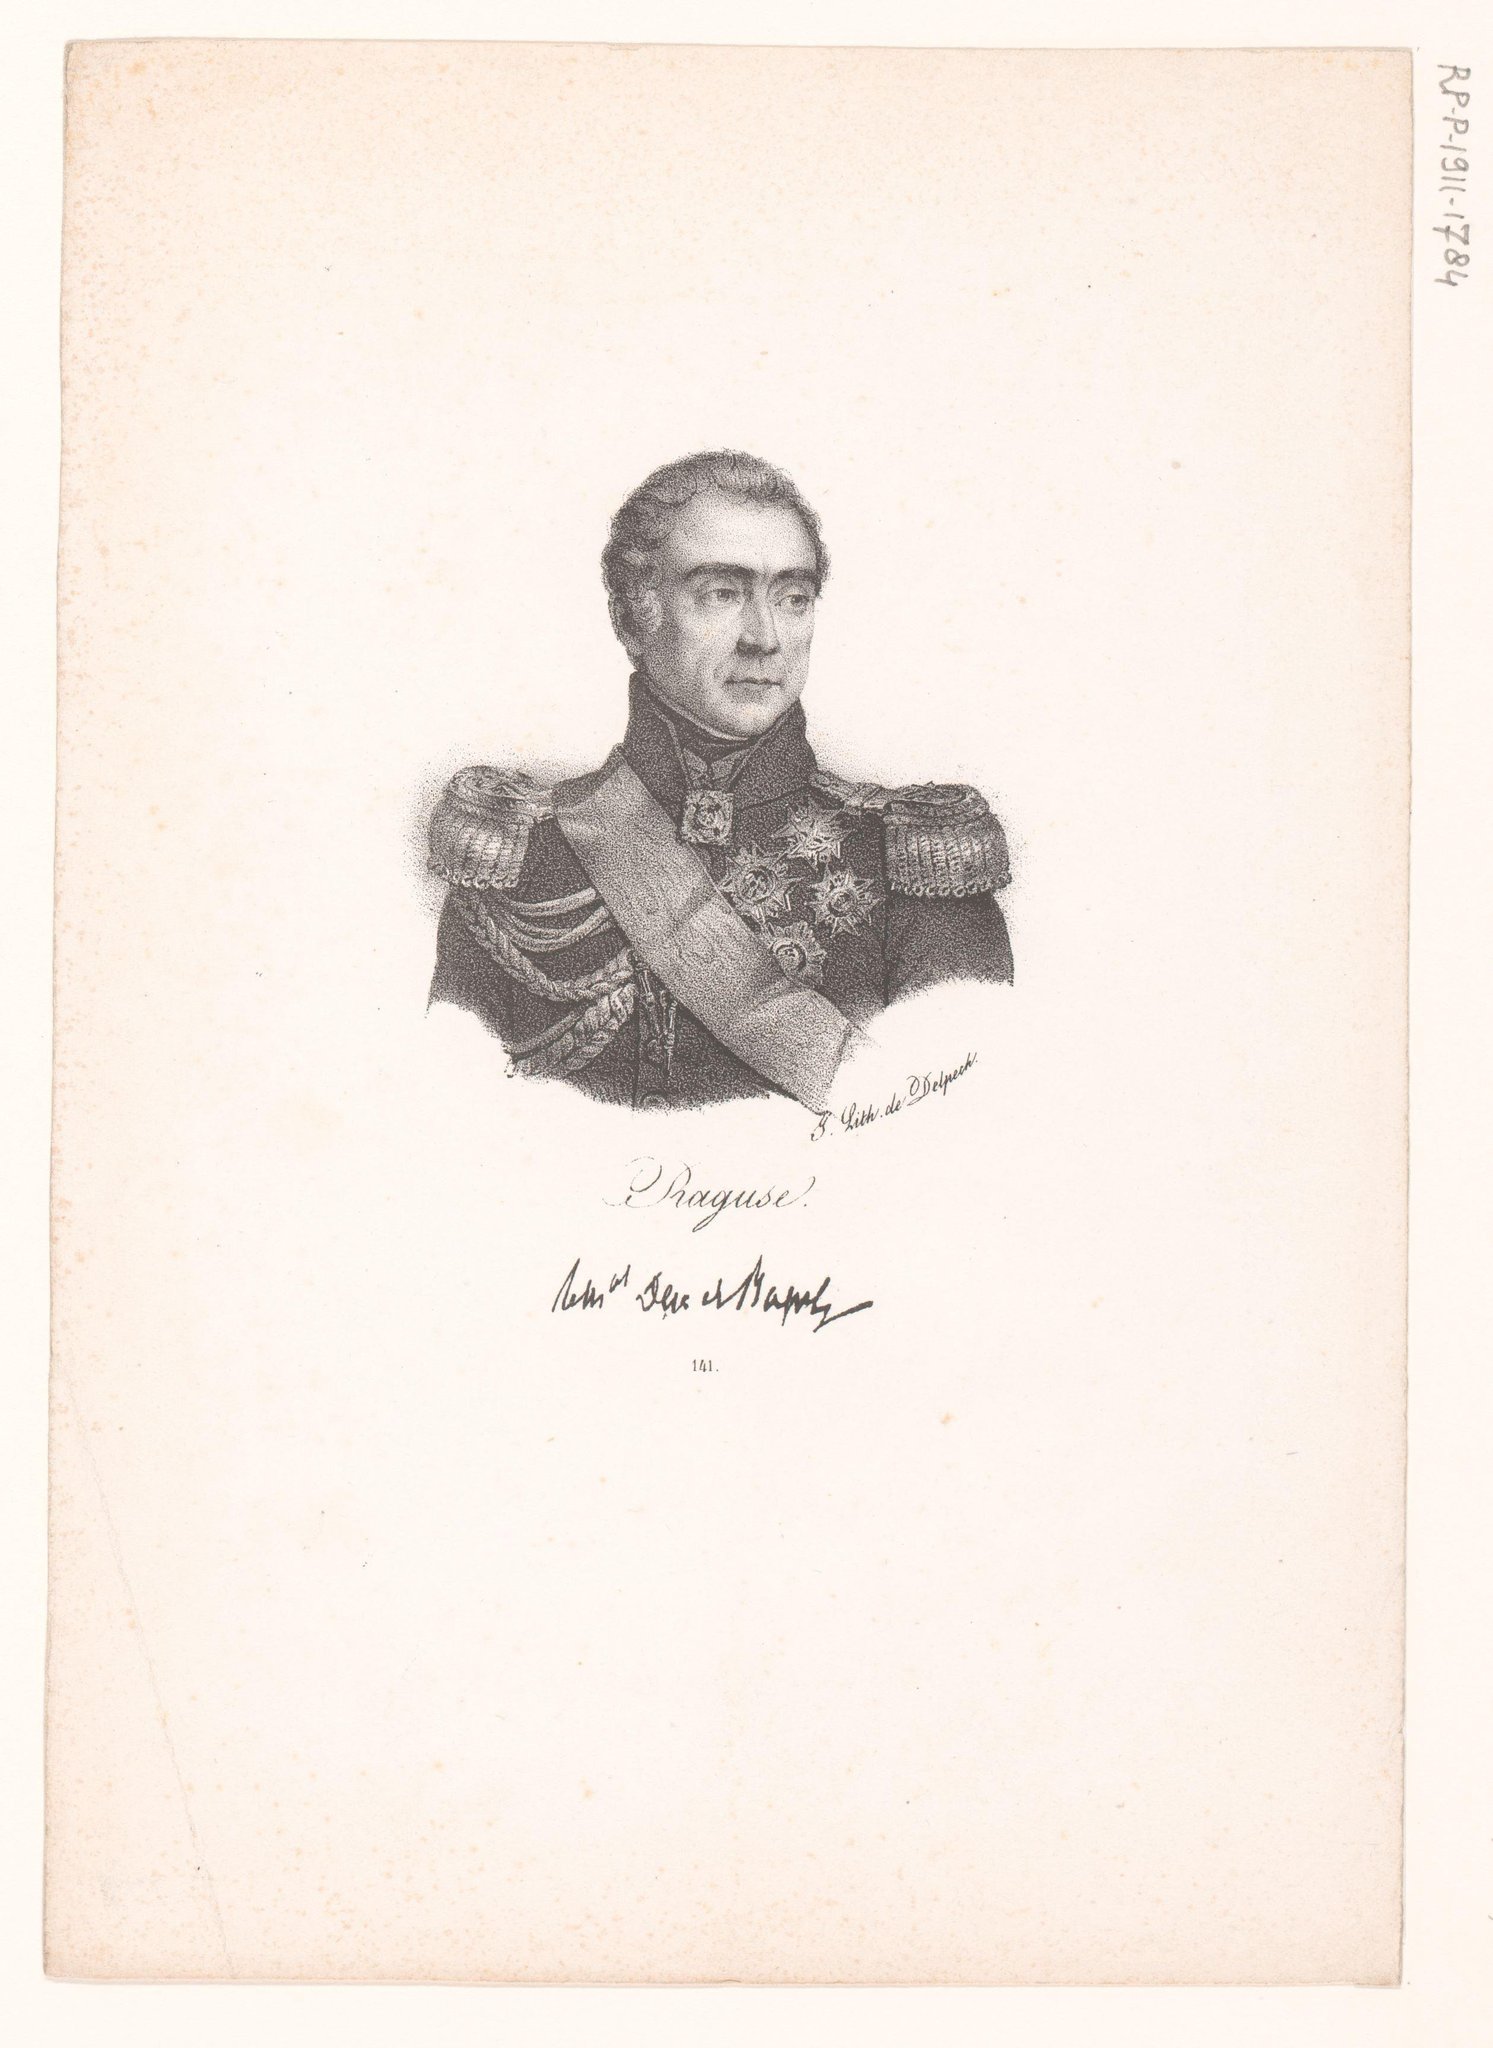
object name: print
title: Portret van Auguste de Marmont, hertog van Ragusa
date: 1818-1842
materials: paper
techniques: lithograph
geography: paris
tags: venice, historical persons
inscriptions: collector's mark: Lugt 2228a